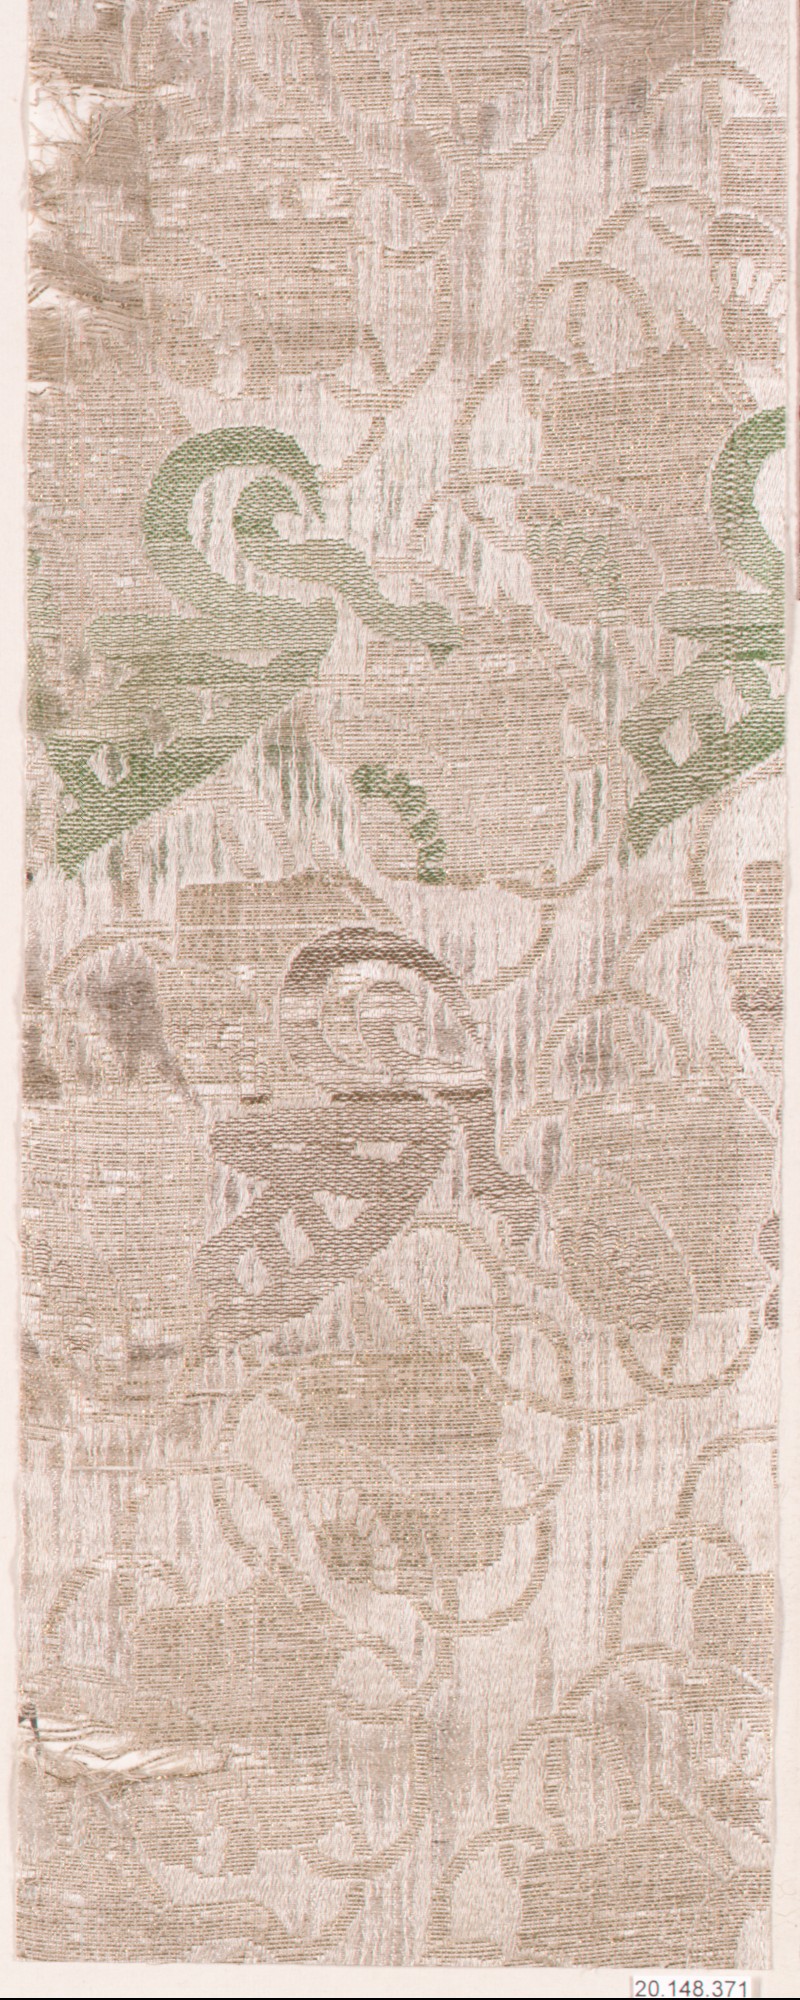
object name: piece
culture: japanese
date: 1701-1800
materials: silk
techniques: compound weave